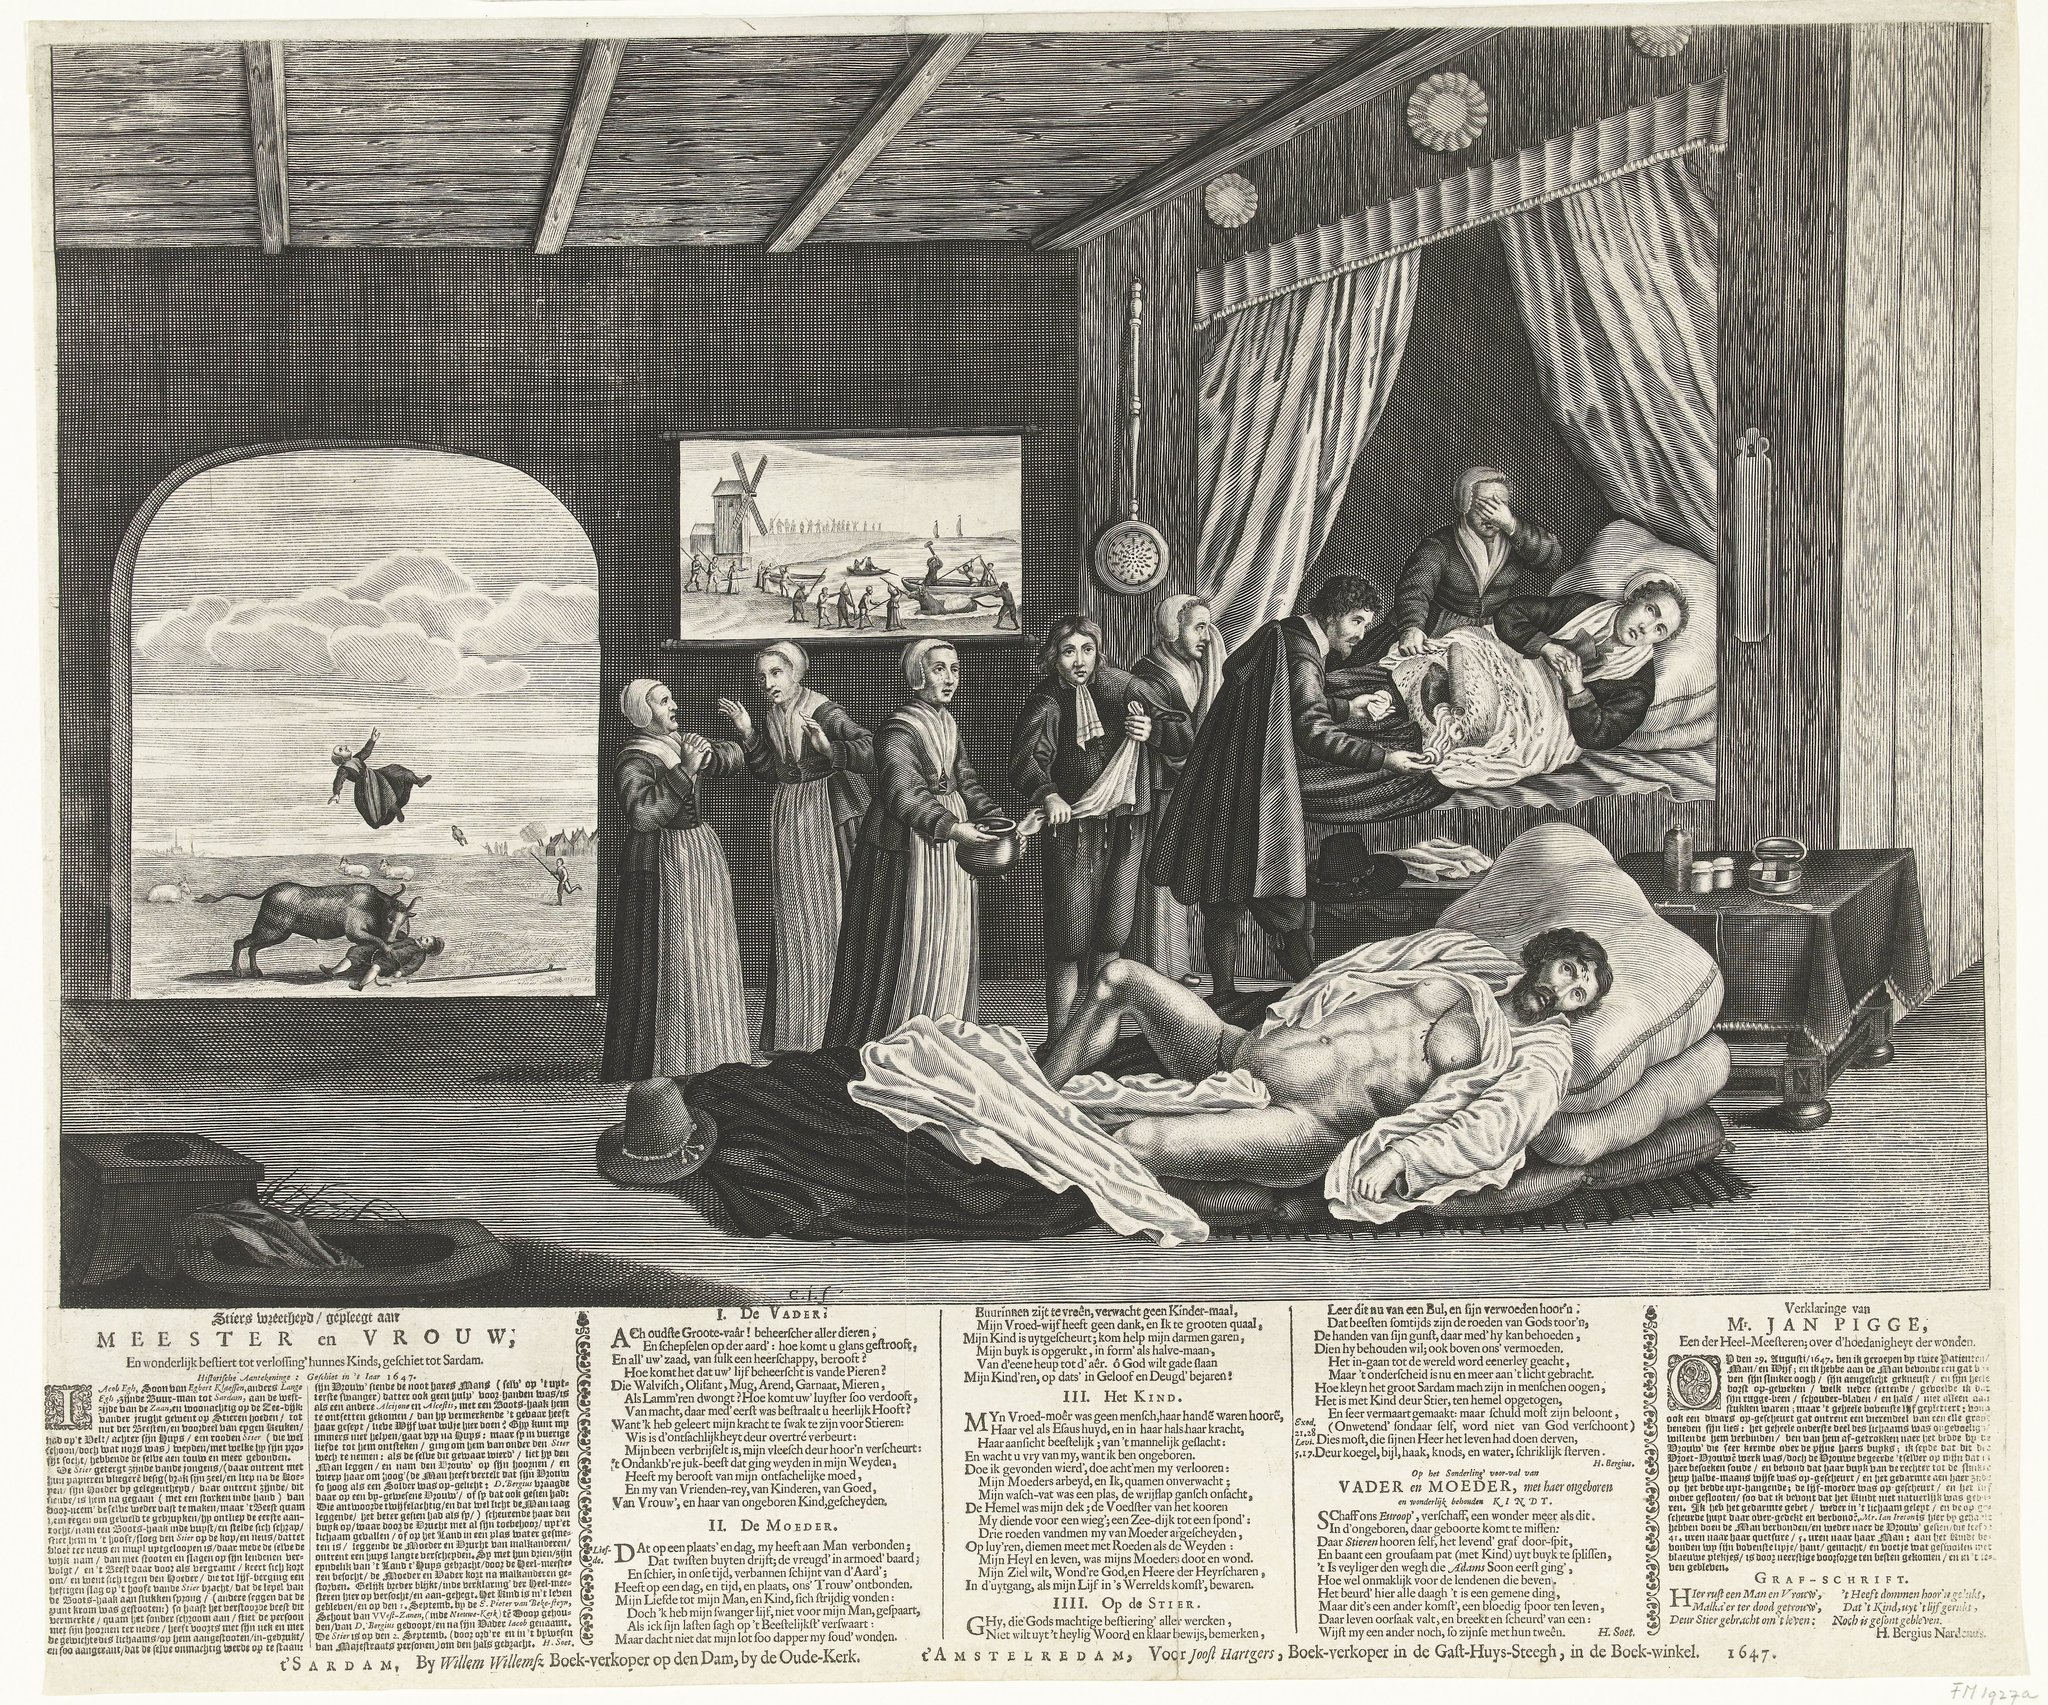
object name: print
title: Stiers wreetheyd, gepleegt aan Meester en Vrouw, En wonderlijk bestiert tot verlossing' hunnes Kinds, geschiet tot Sardam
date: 1647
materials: paper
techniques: engraving, letterpress printing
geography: northern netherlands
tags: bull, difficult and unusual birth, infections and wounds, medical examination, medical treatment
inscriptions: date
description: Illustratie van de gebeurtenissen die bekend staan als de wreedheid van de stier, 1647. De boer en zijn zwangere echtgenote die op 29 augustus 1647 te Zaandam door een stier werden aangevallen. De zwangere vrouw wordt op de horens genomen waarbij het kind uit de buik wordt geslingerd. De prent toont een interieur waarin de dodelijke gewonde boer en boerin liggen. Op de achtergrond is in twee scènes te zien hoe de man en de vrouw door de stier worden aangevallen en hoe de stier uiteindelijk wordt afgemaakt. Onder de voorstelling een beschrijving van de gebeurtenissen, verschillende verzen over de hoofdrolspelers en een verklaring van de betrokken arts, in 5 kolommen.